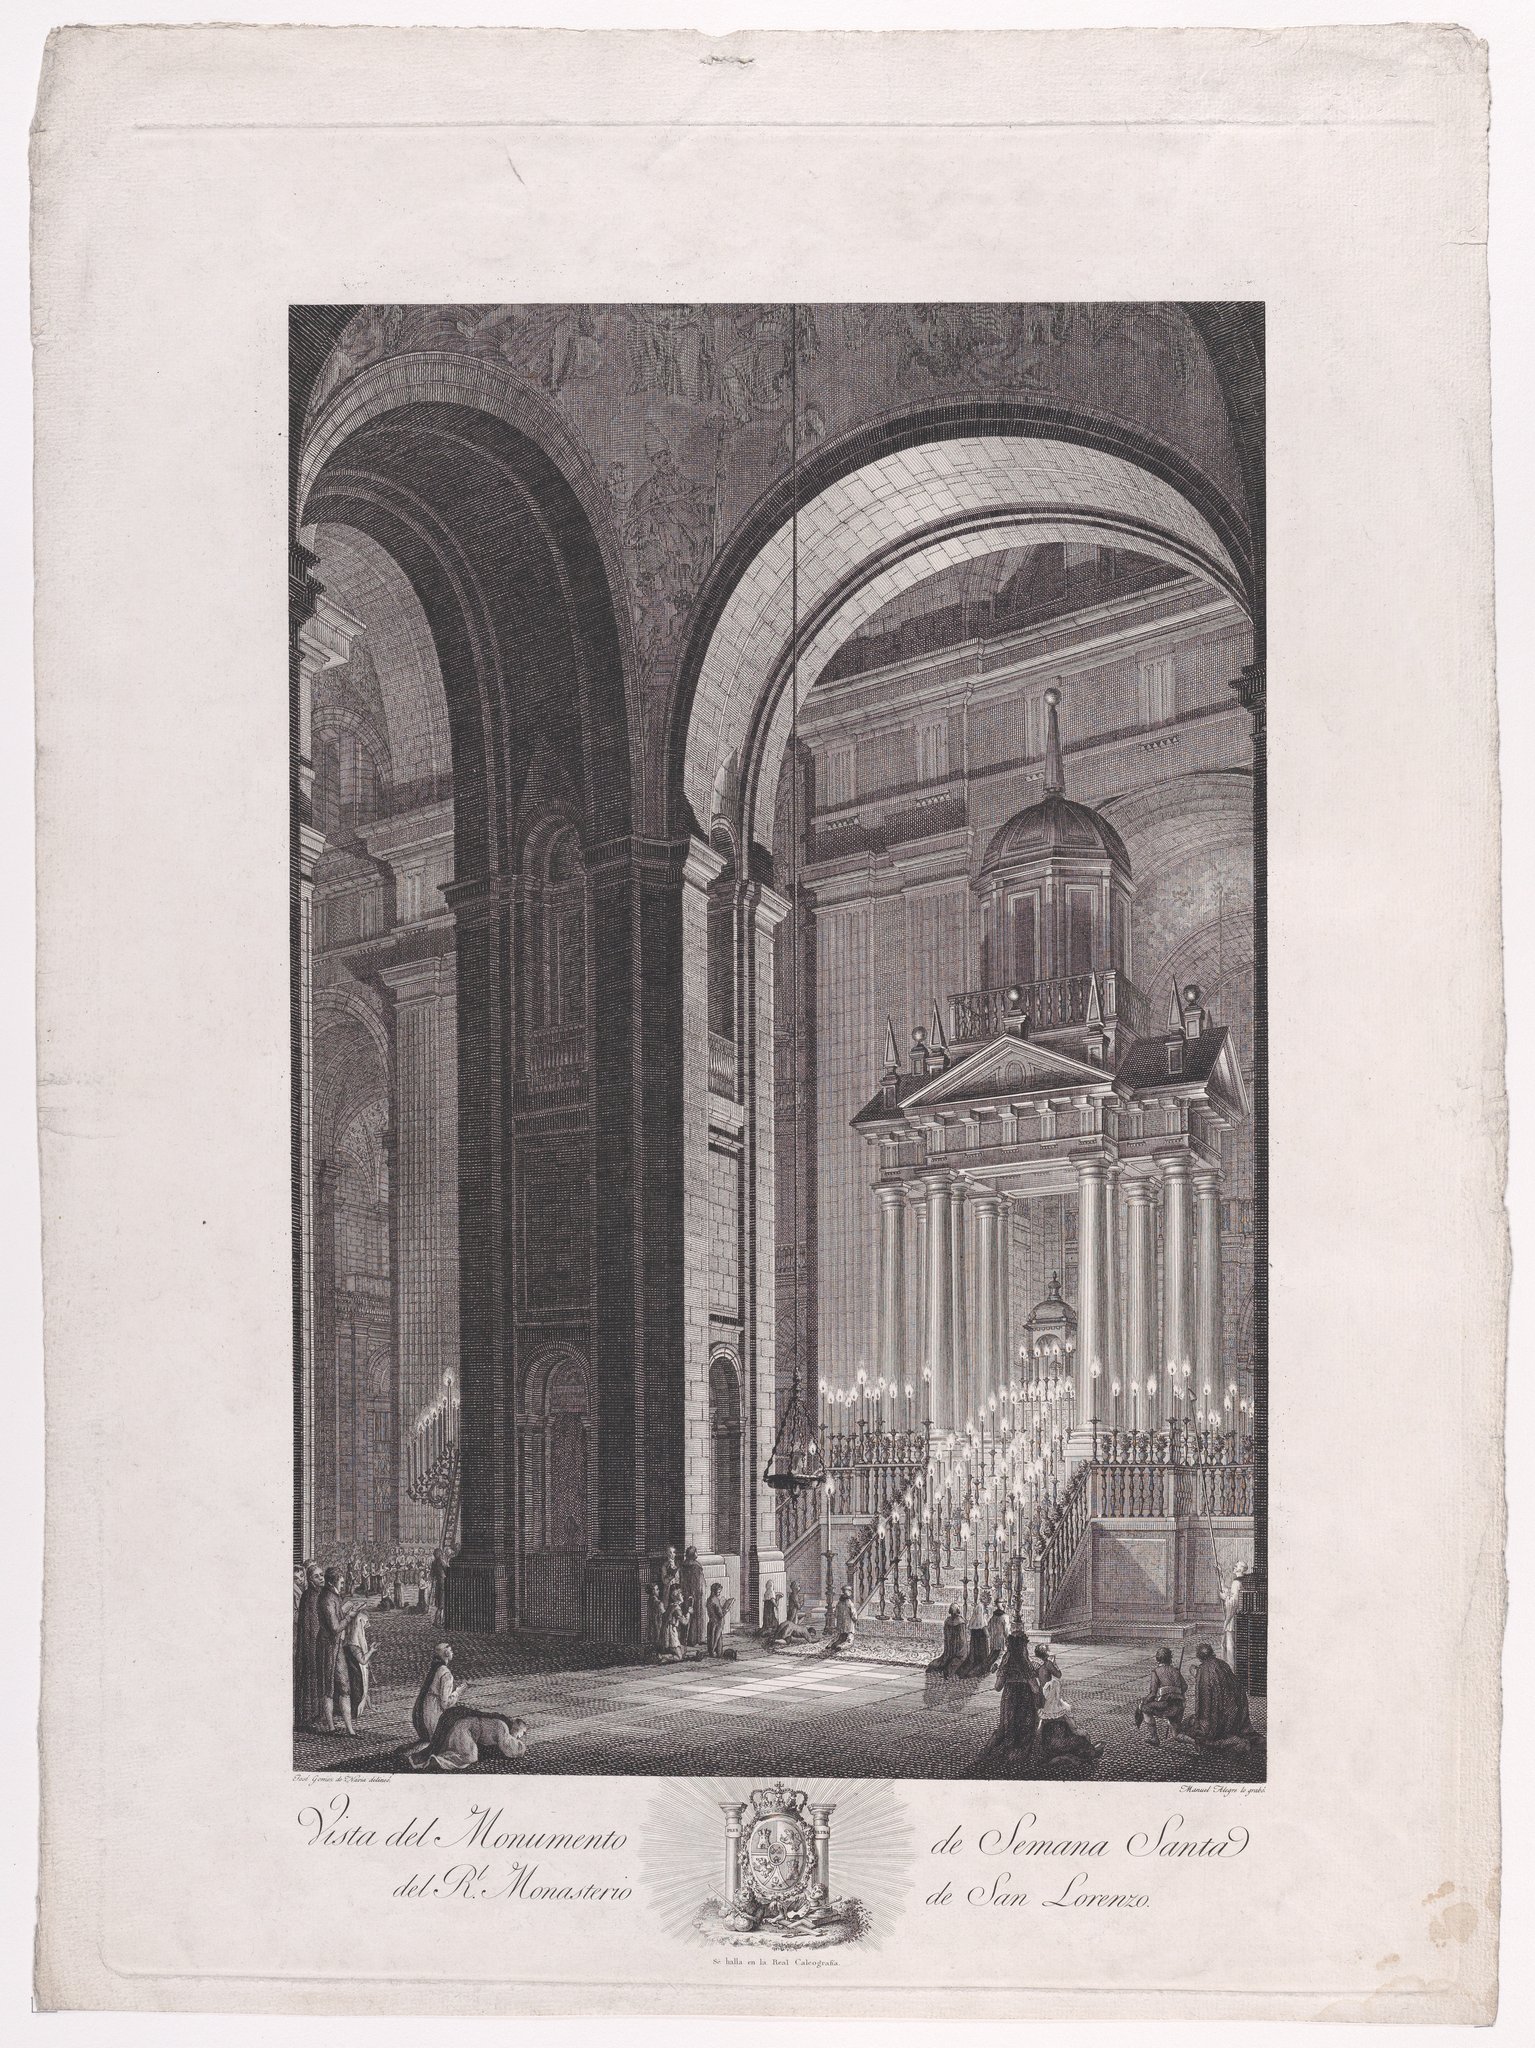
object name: print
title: The monument raised for Holy Week (Semana Santa) in the Church of the monastery of El Escorial, from a series of Views of El Escorial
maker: manuel alegre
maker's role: artist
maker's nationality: spanish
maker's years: 1768-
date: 1790-1800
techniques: engraving, etching